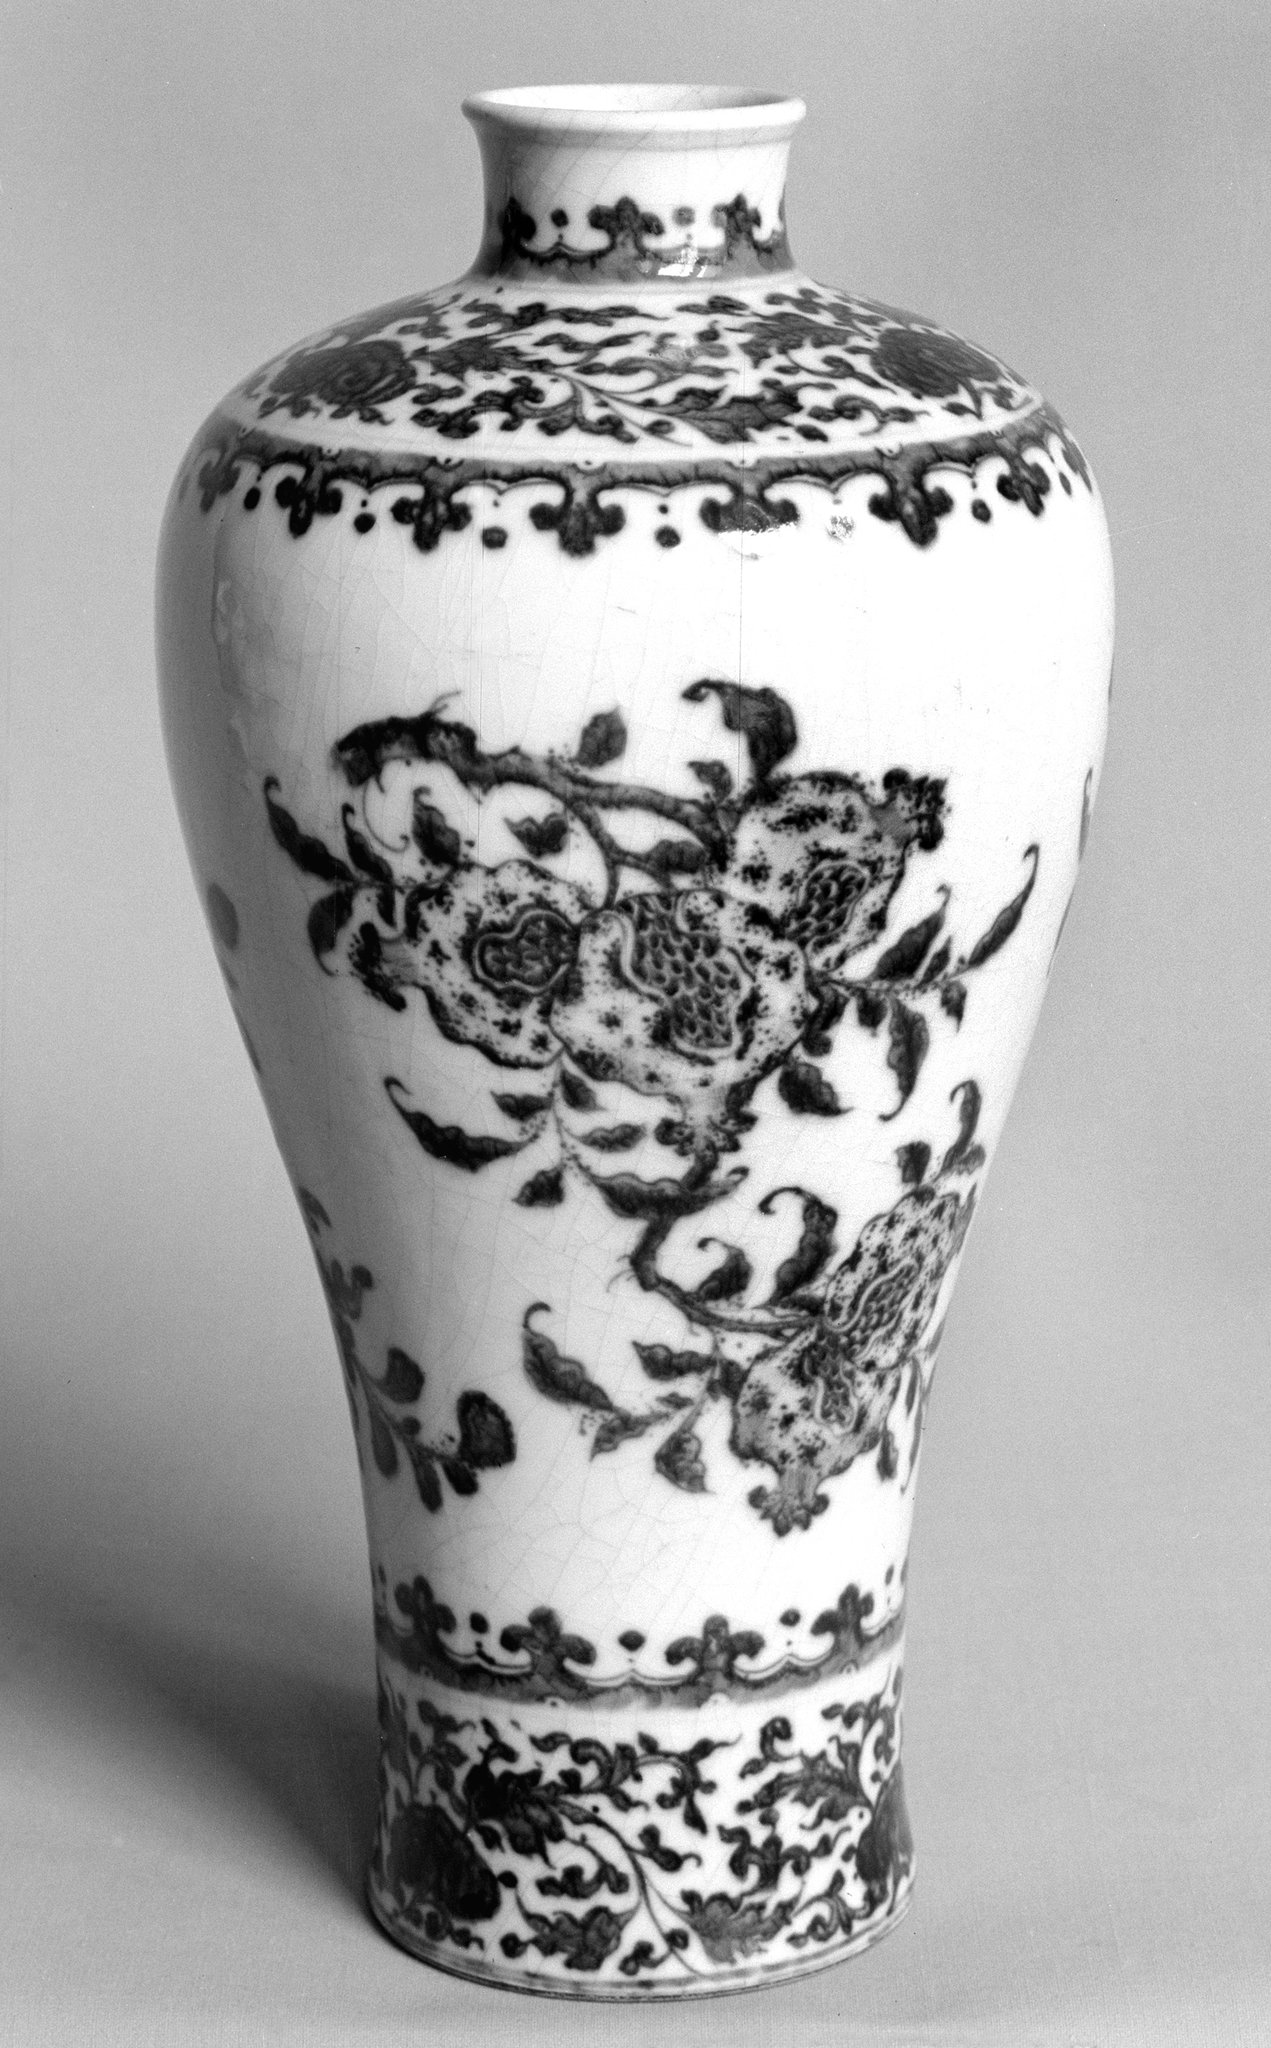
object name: vase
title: Meiping vase with peach, pomegranade, and fingered citron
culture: chinese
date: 1701-1800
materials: cobalt, soft paste porcelain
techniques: painting, underglaze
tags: flowers